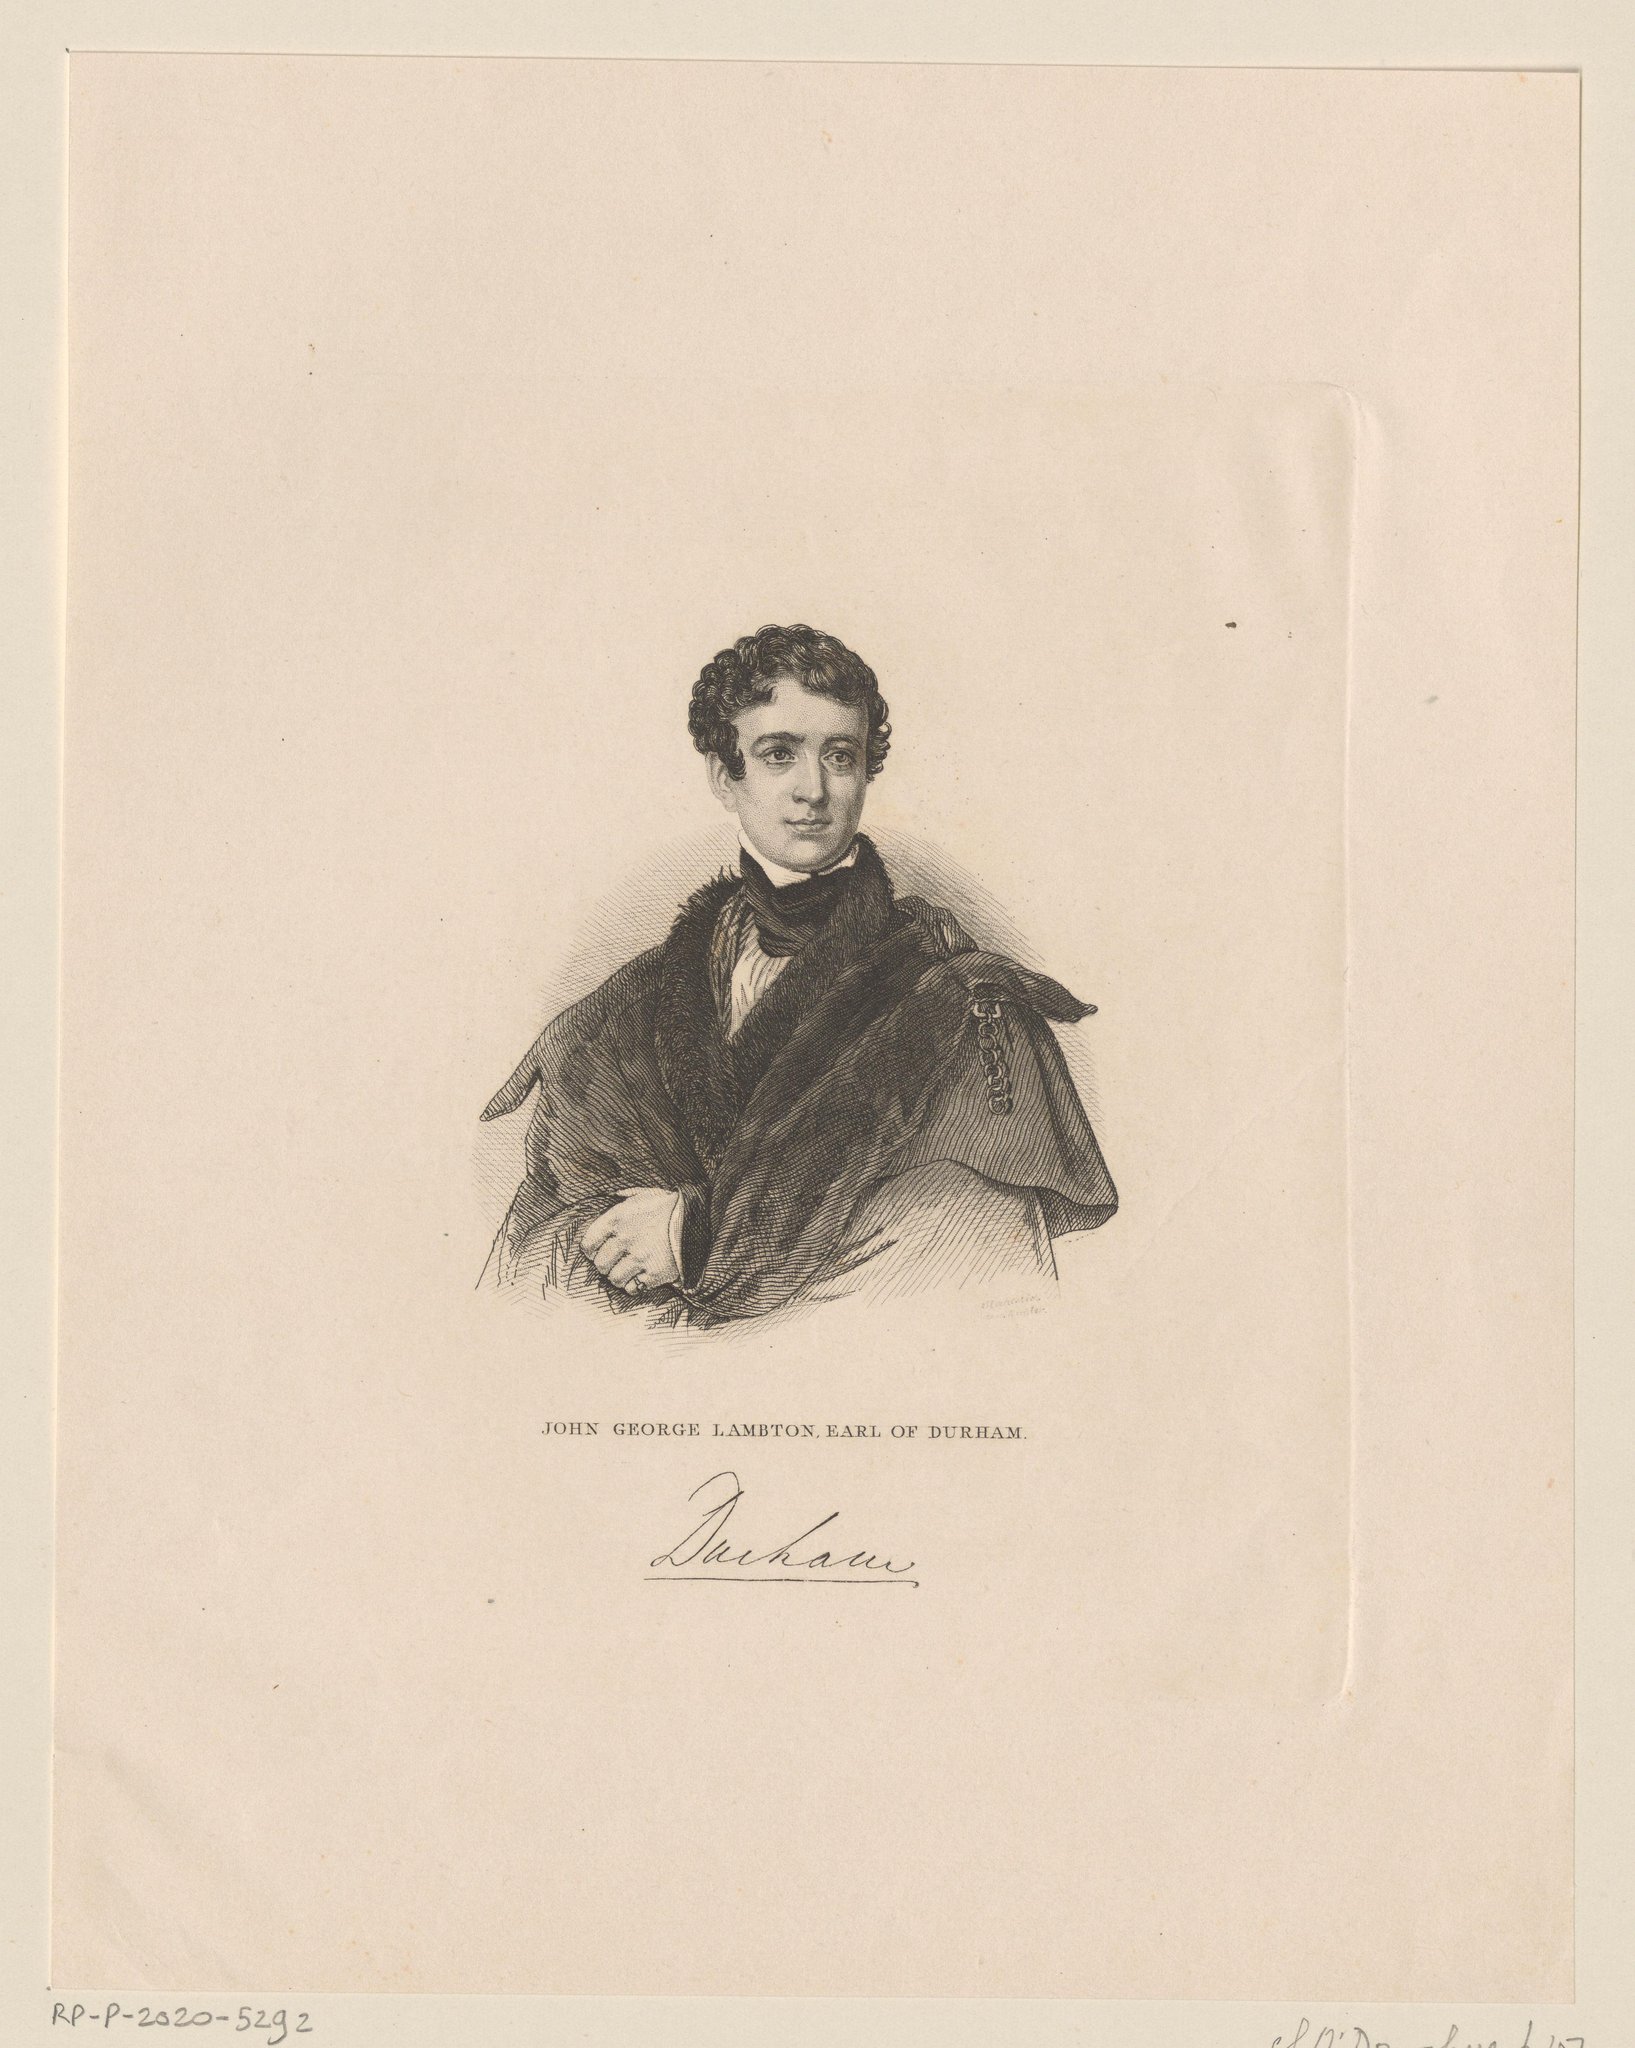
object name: print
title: Portret van John George Lambton, 1e graaf van Durham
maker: richter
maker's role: print maker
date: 1810-1898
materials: paper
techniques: engraving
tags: historical persons, governor, etc. of province